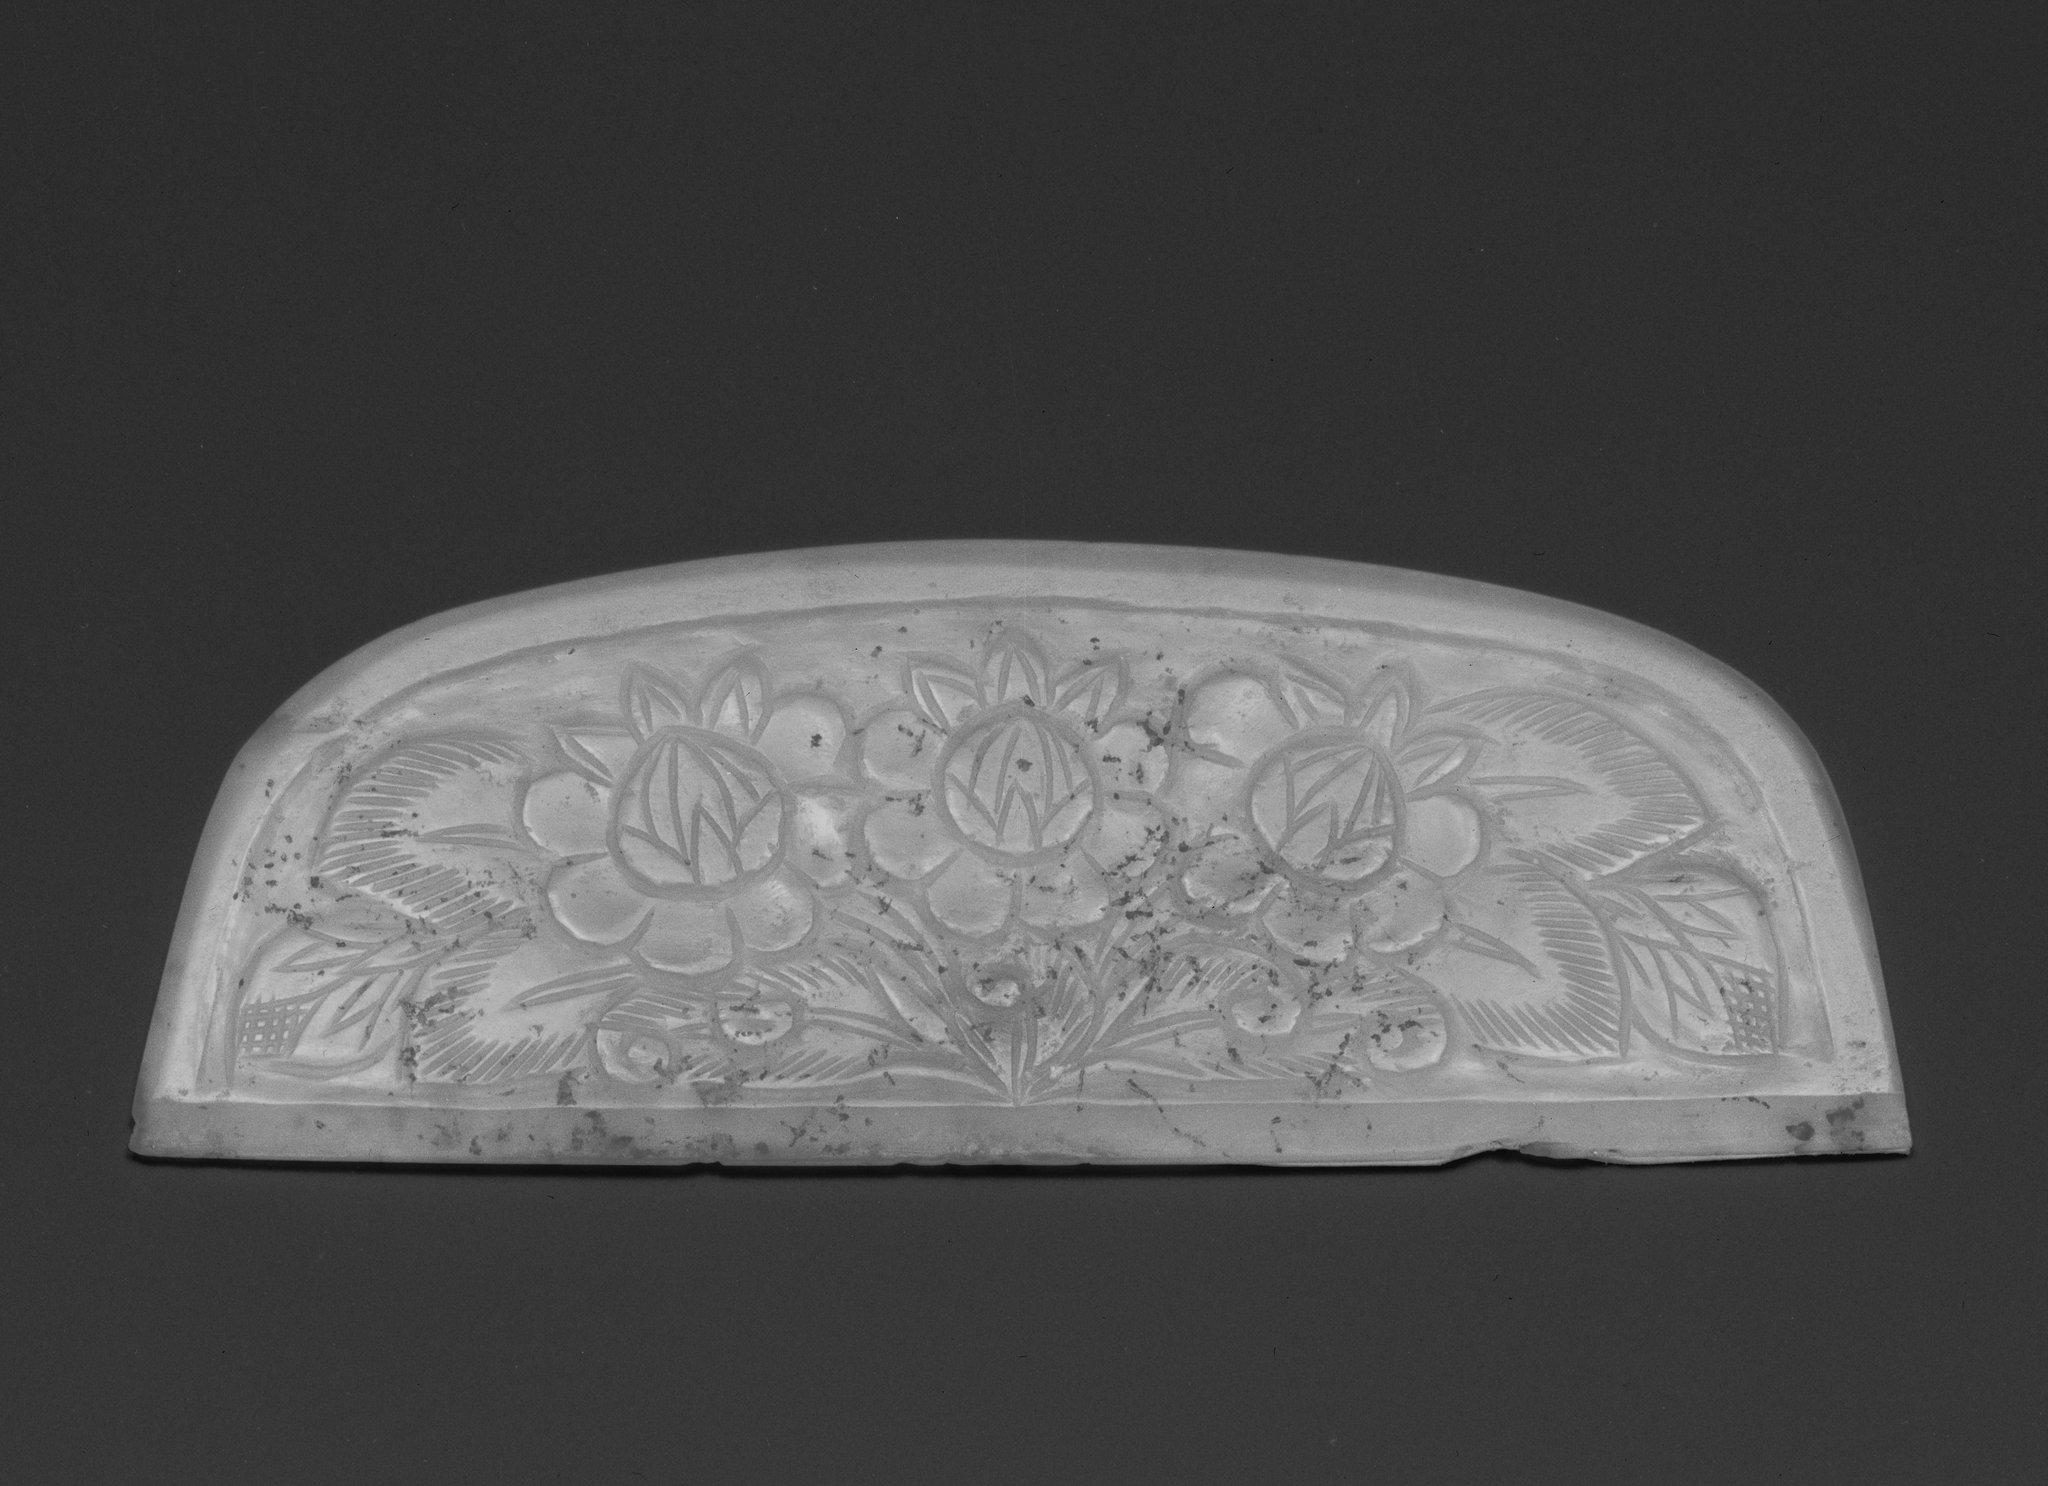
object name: comb top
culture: chinese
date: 901-1000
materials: jade